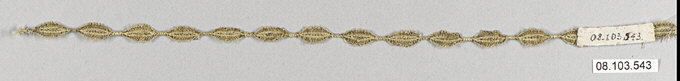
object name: galloon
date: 1734-1766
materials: cotton, metal thread